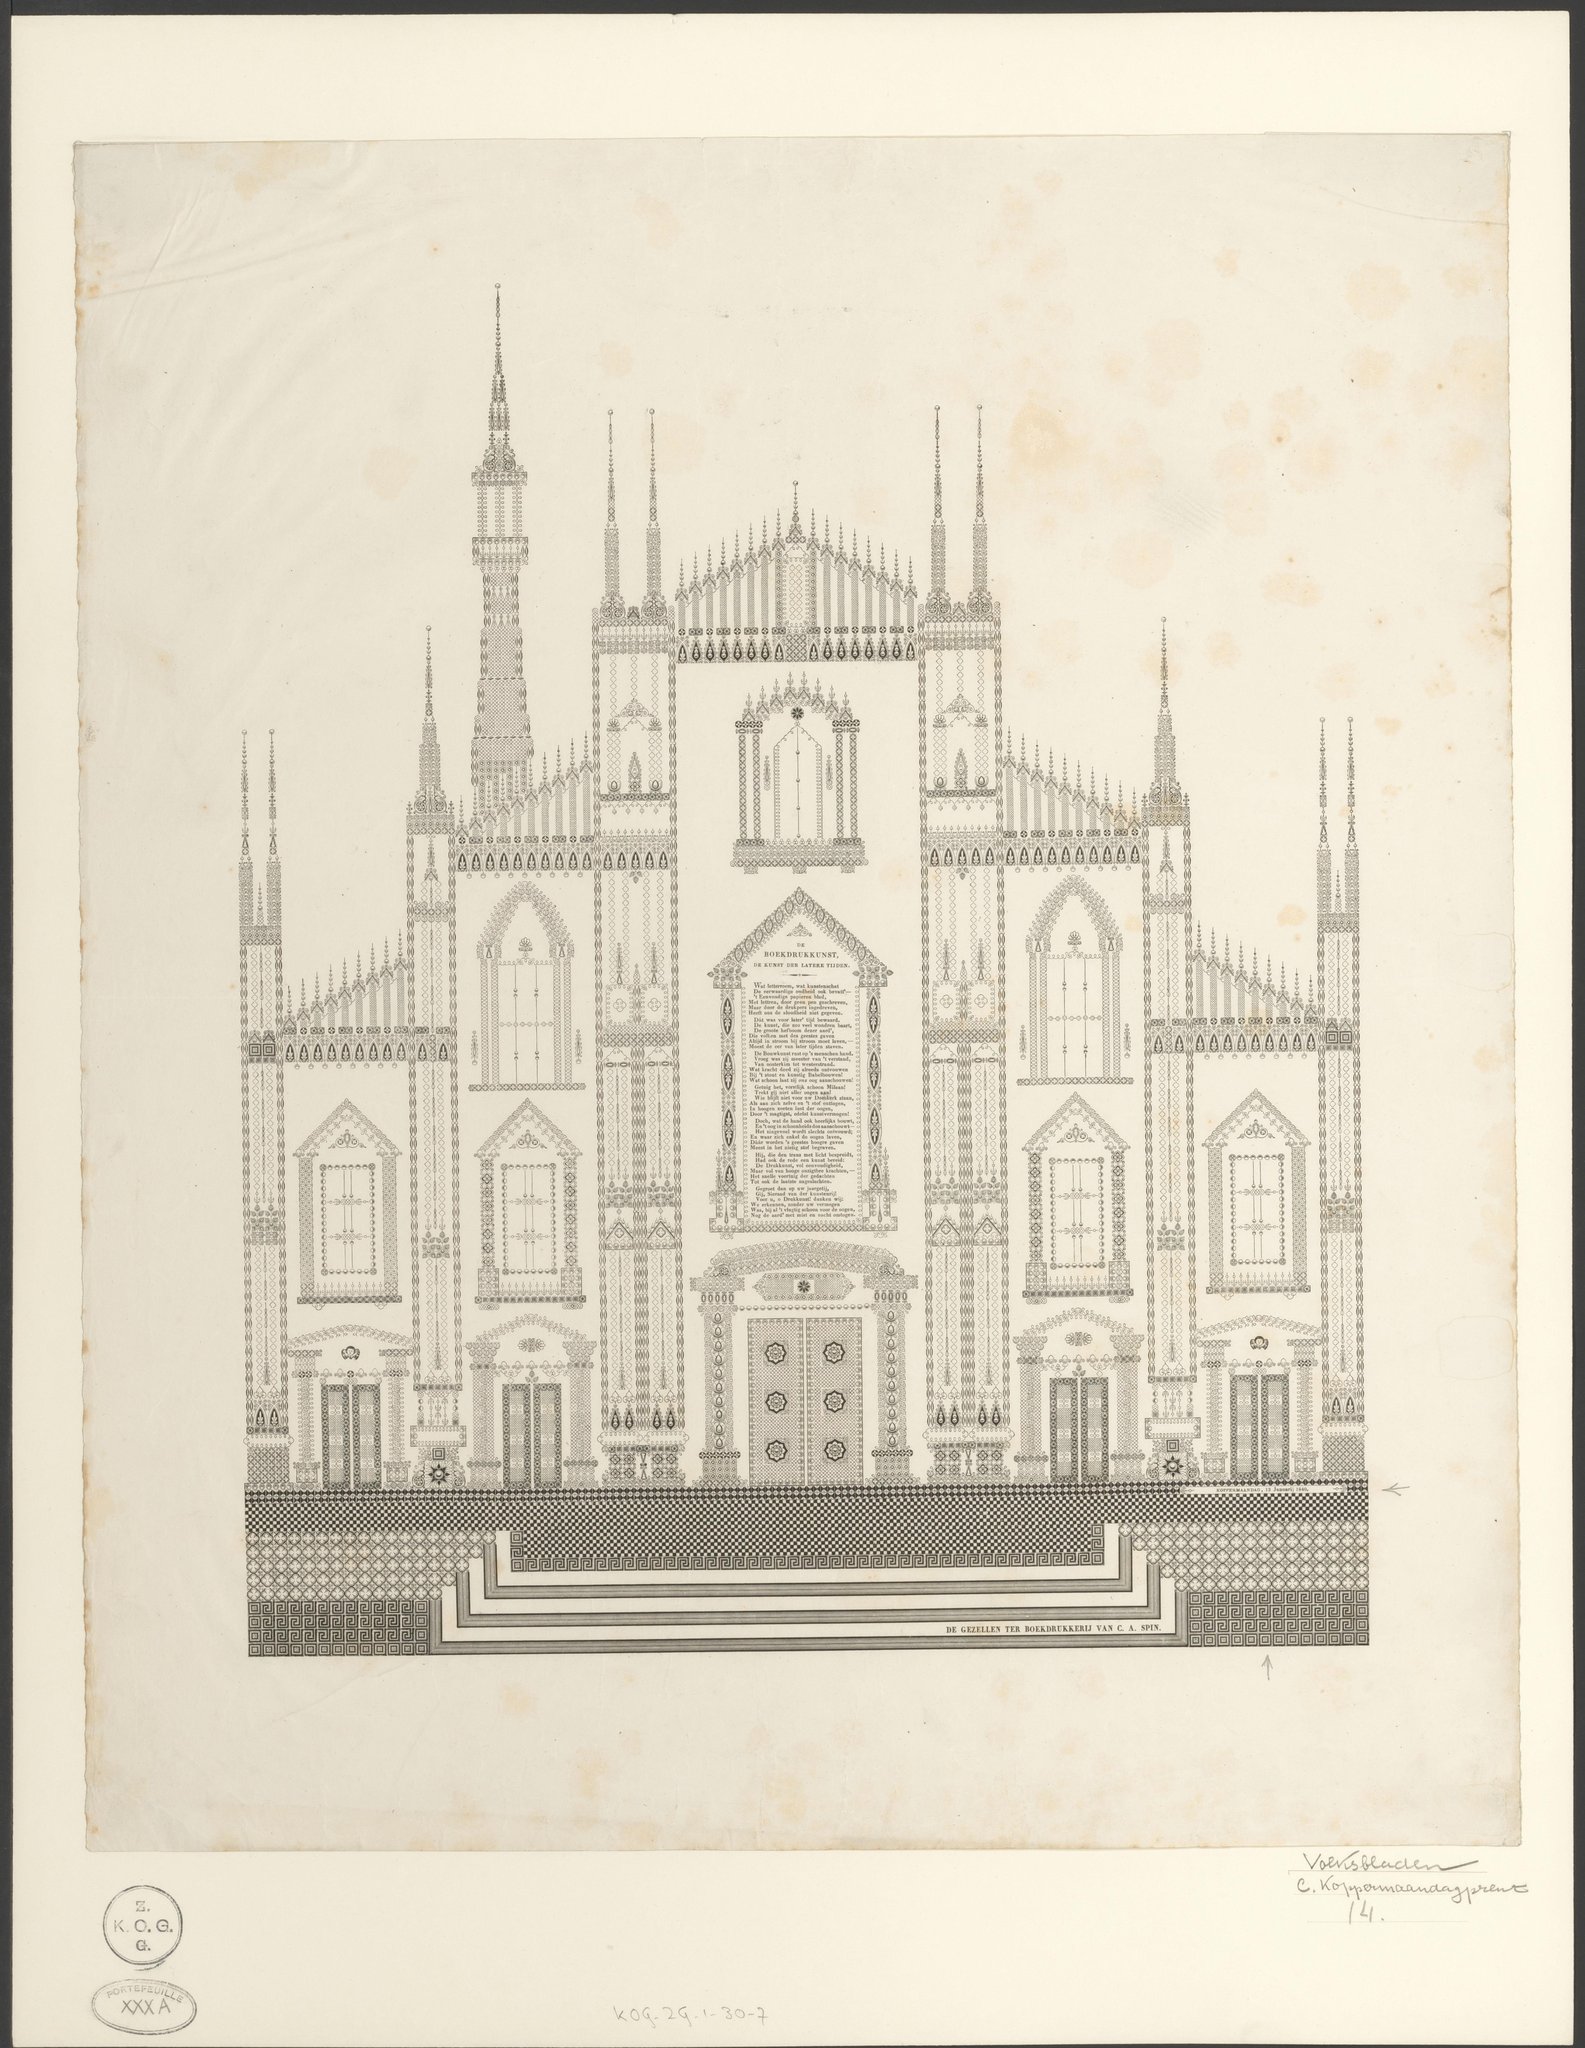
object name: photomechanical print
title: De Boekdrukkunst, de kunst der latere tijden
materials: paper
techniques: letterpress printing, printing block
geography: amsterdam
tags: 'blue monday', church (exterior)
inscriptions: collector's mark: Lugt 1641, stamp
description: Koppermaandagprent door de gezellen van de boekdrukkerij van C.A. Spin te Amsterdam, ter gelegenheid van Koppermaandag 13 januari 1840. Op de voorzijde de versierde gevel van een Dom. In het midden van de Dom een vers namens de gezellen. Onderwerpsrubrieken binnen de Atlas Zeden en Gewoonten: Zeden en Gewoonten in engeren zin. Volksleven. Volksbladen. Koppermaandagwenschen.